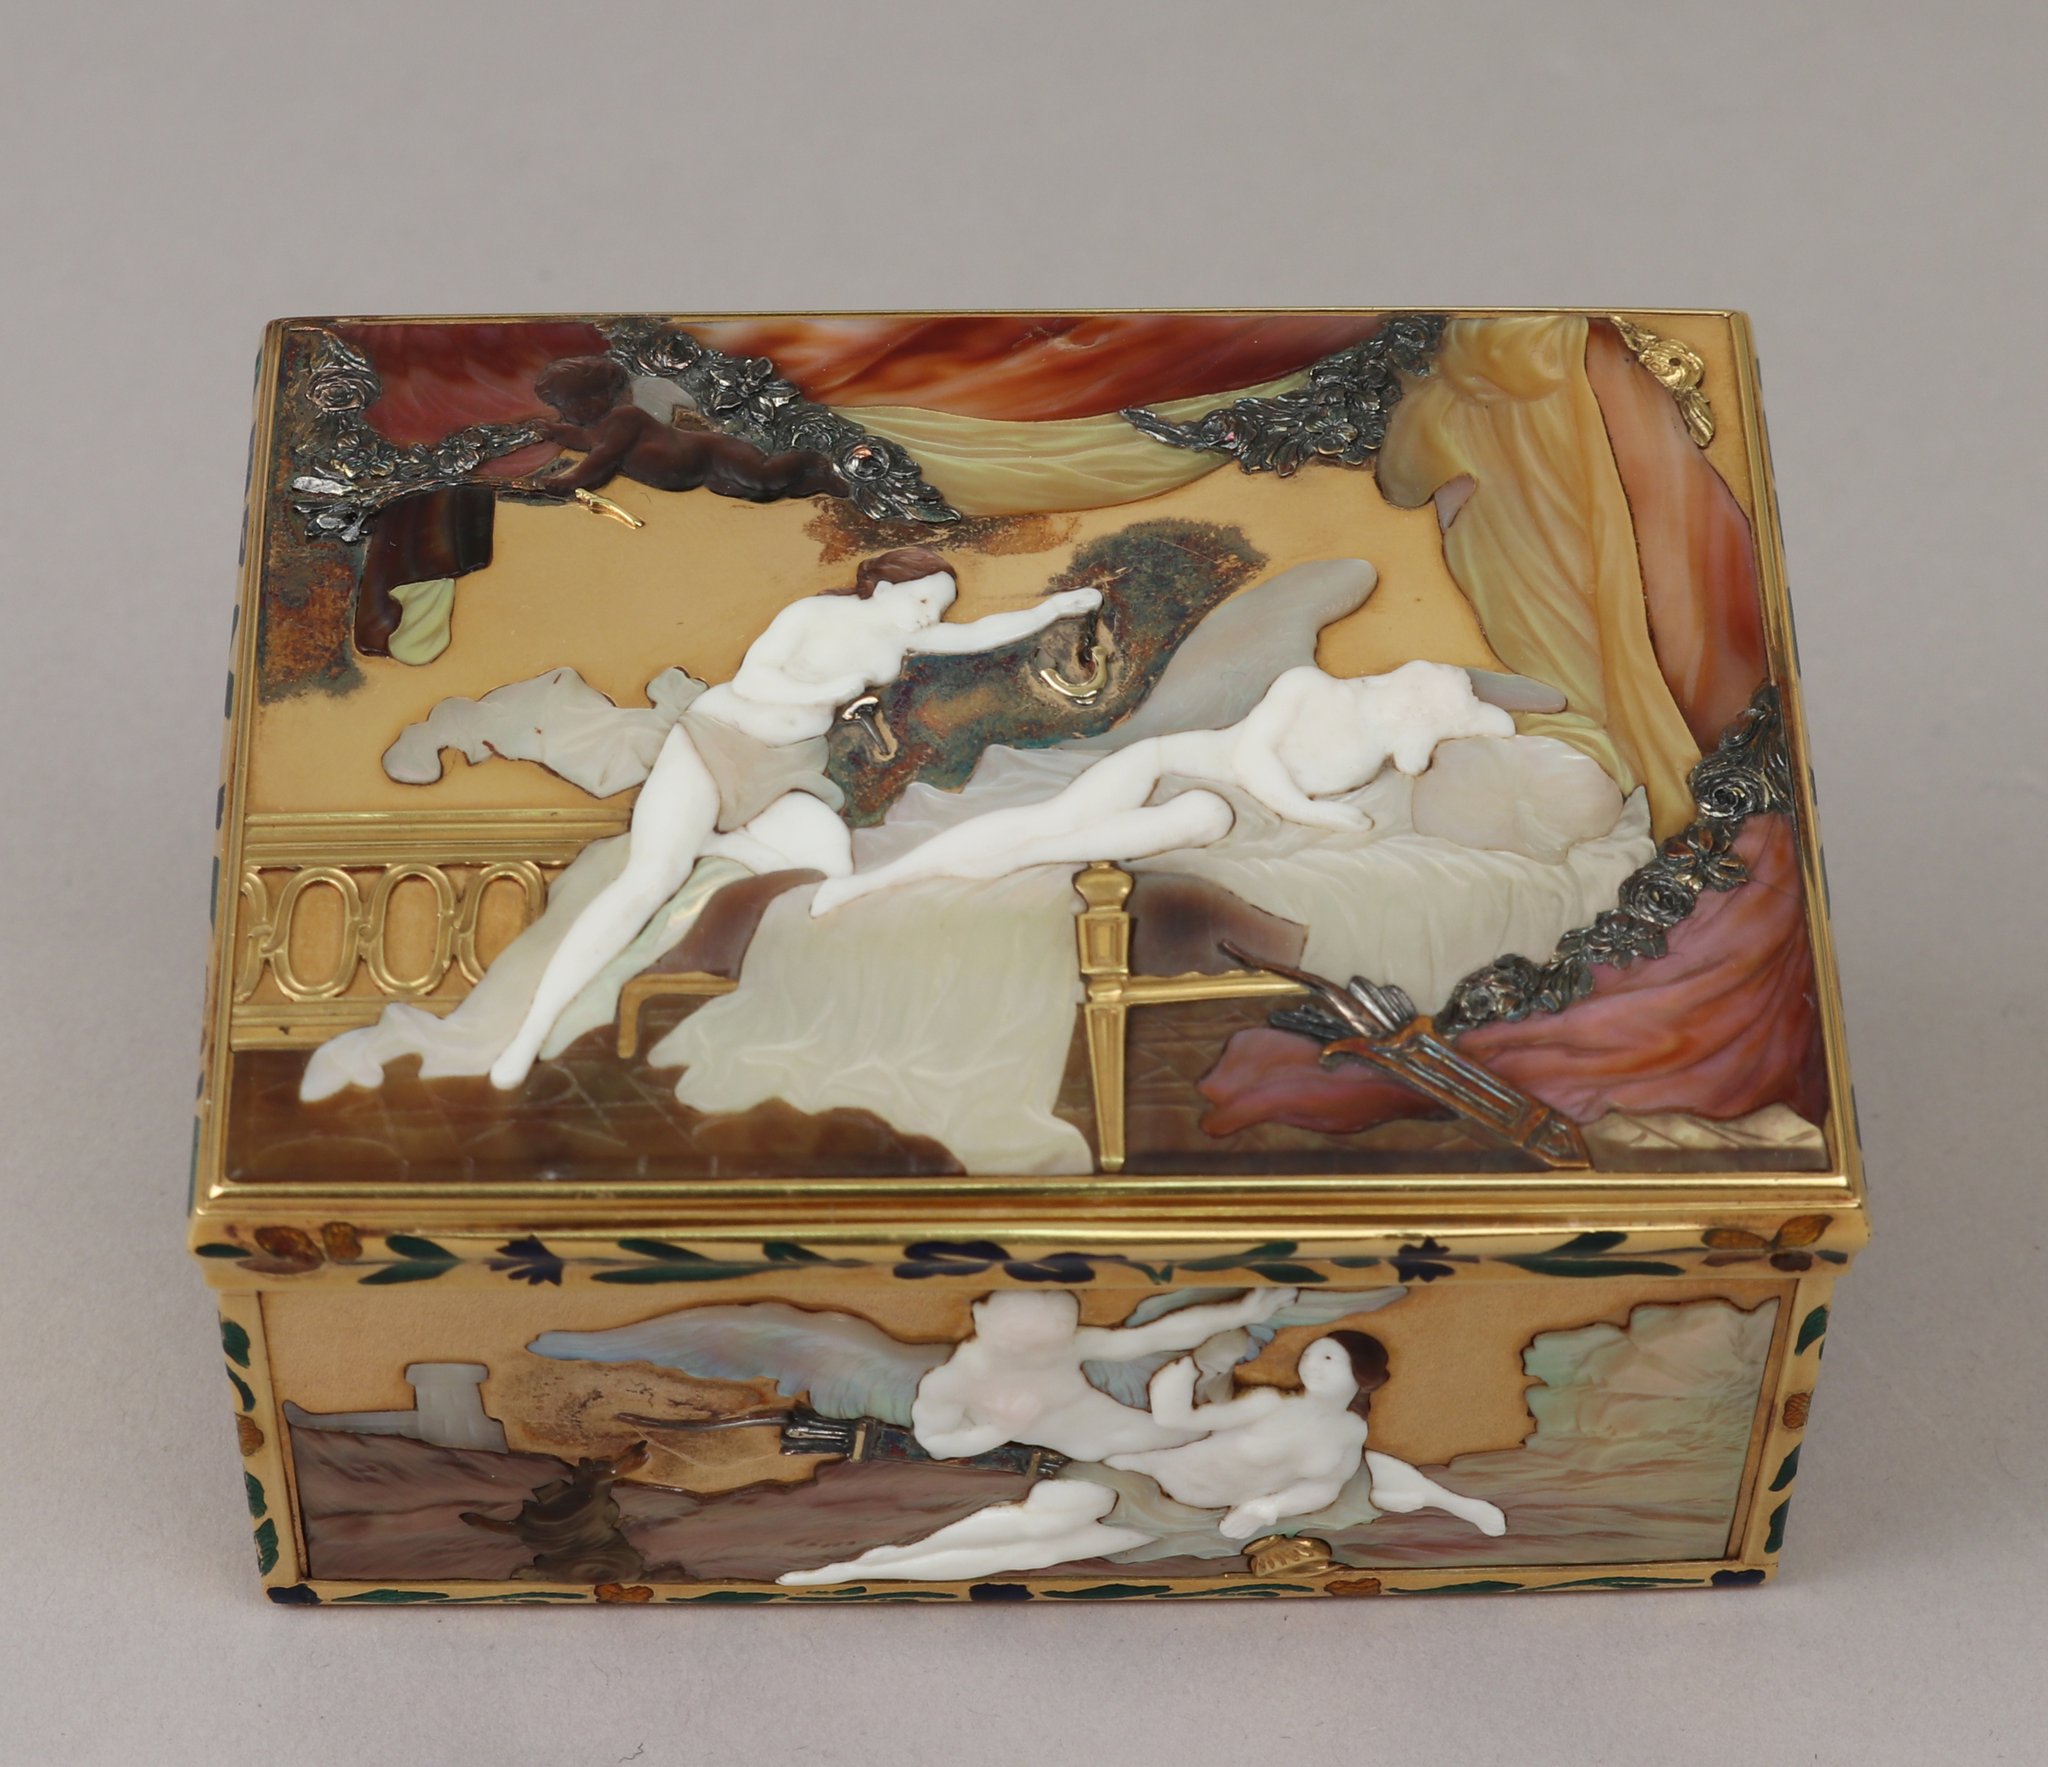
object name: snuffbox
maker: claude de villers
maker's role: maker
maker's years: 1655-1755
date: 1750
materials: enamel, gold, ivory, mother of pearl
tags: female nudes,cupid